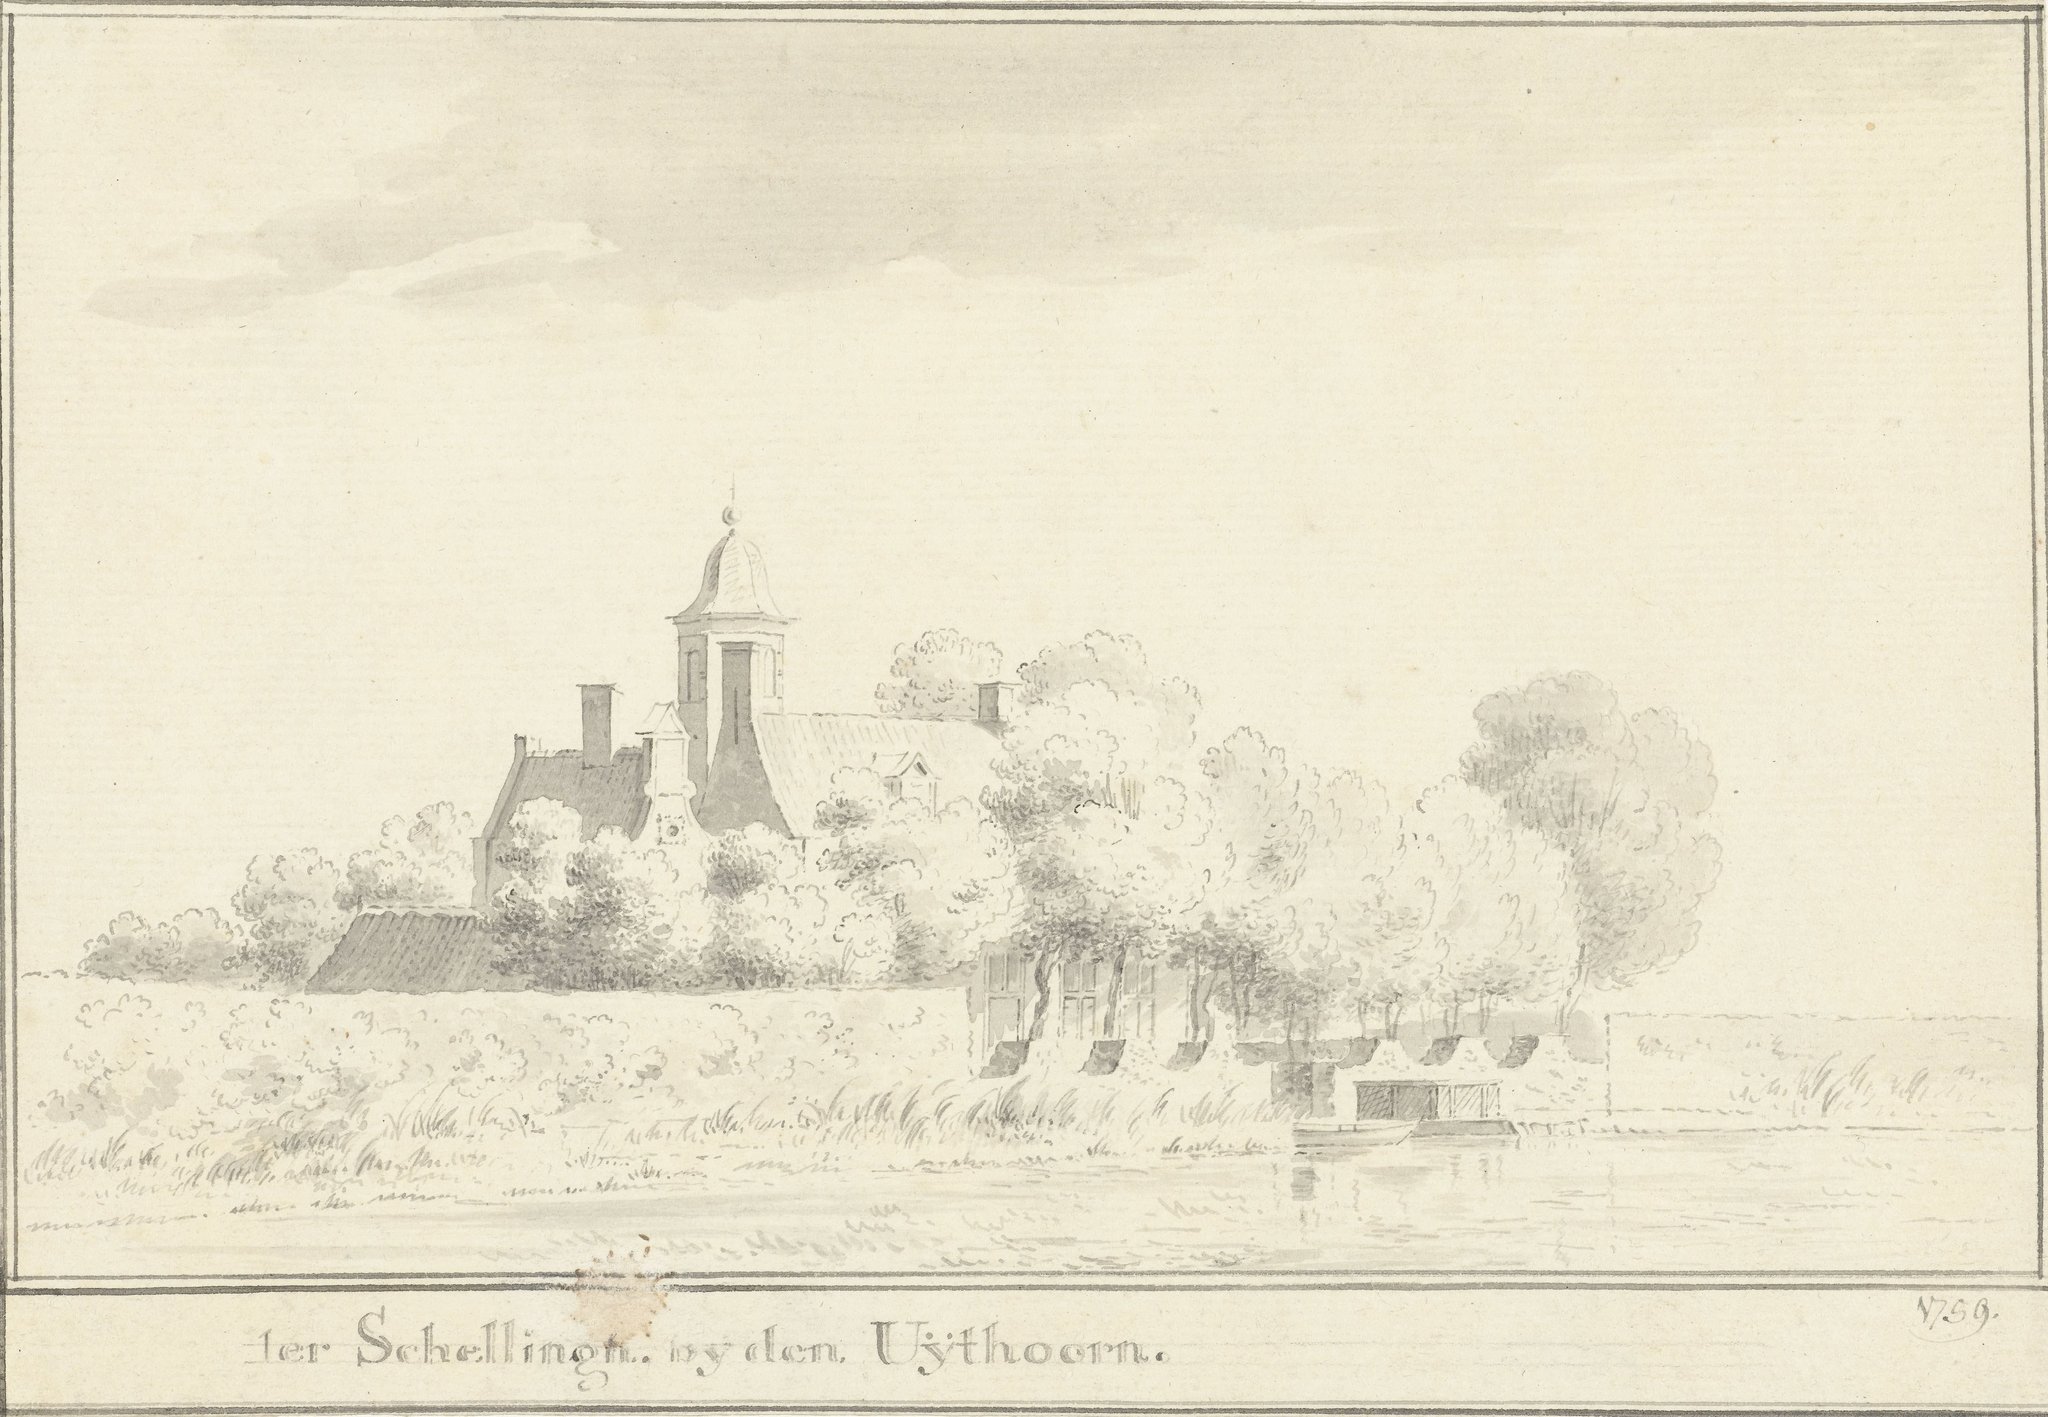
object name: drawing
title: Het huis ter Schelling bij Uithoorn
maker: cornelis pronk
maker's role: draughtsman, painter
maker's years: 1691-1759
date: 1759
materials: ink, paper, pencil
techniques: brush, pen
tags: castle